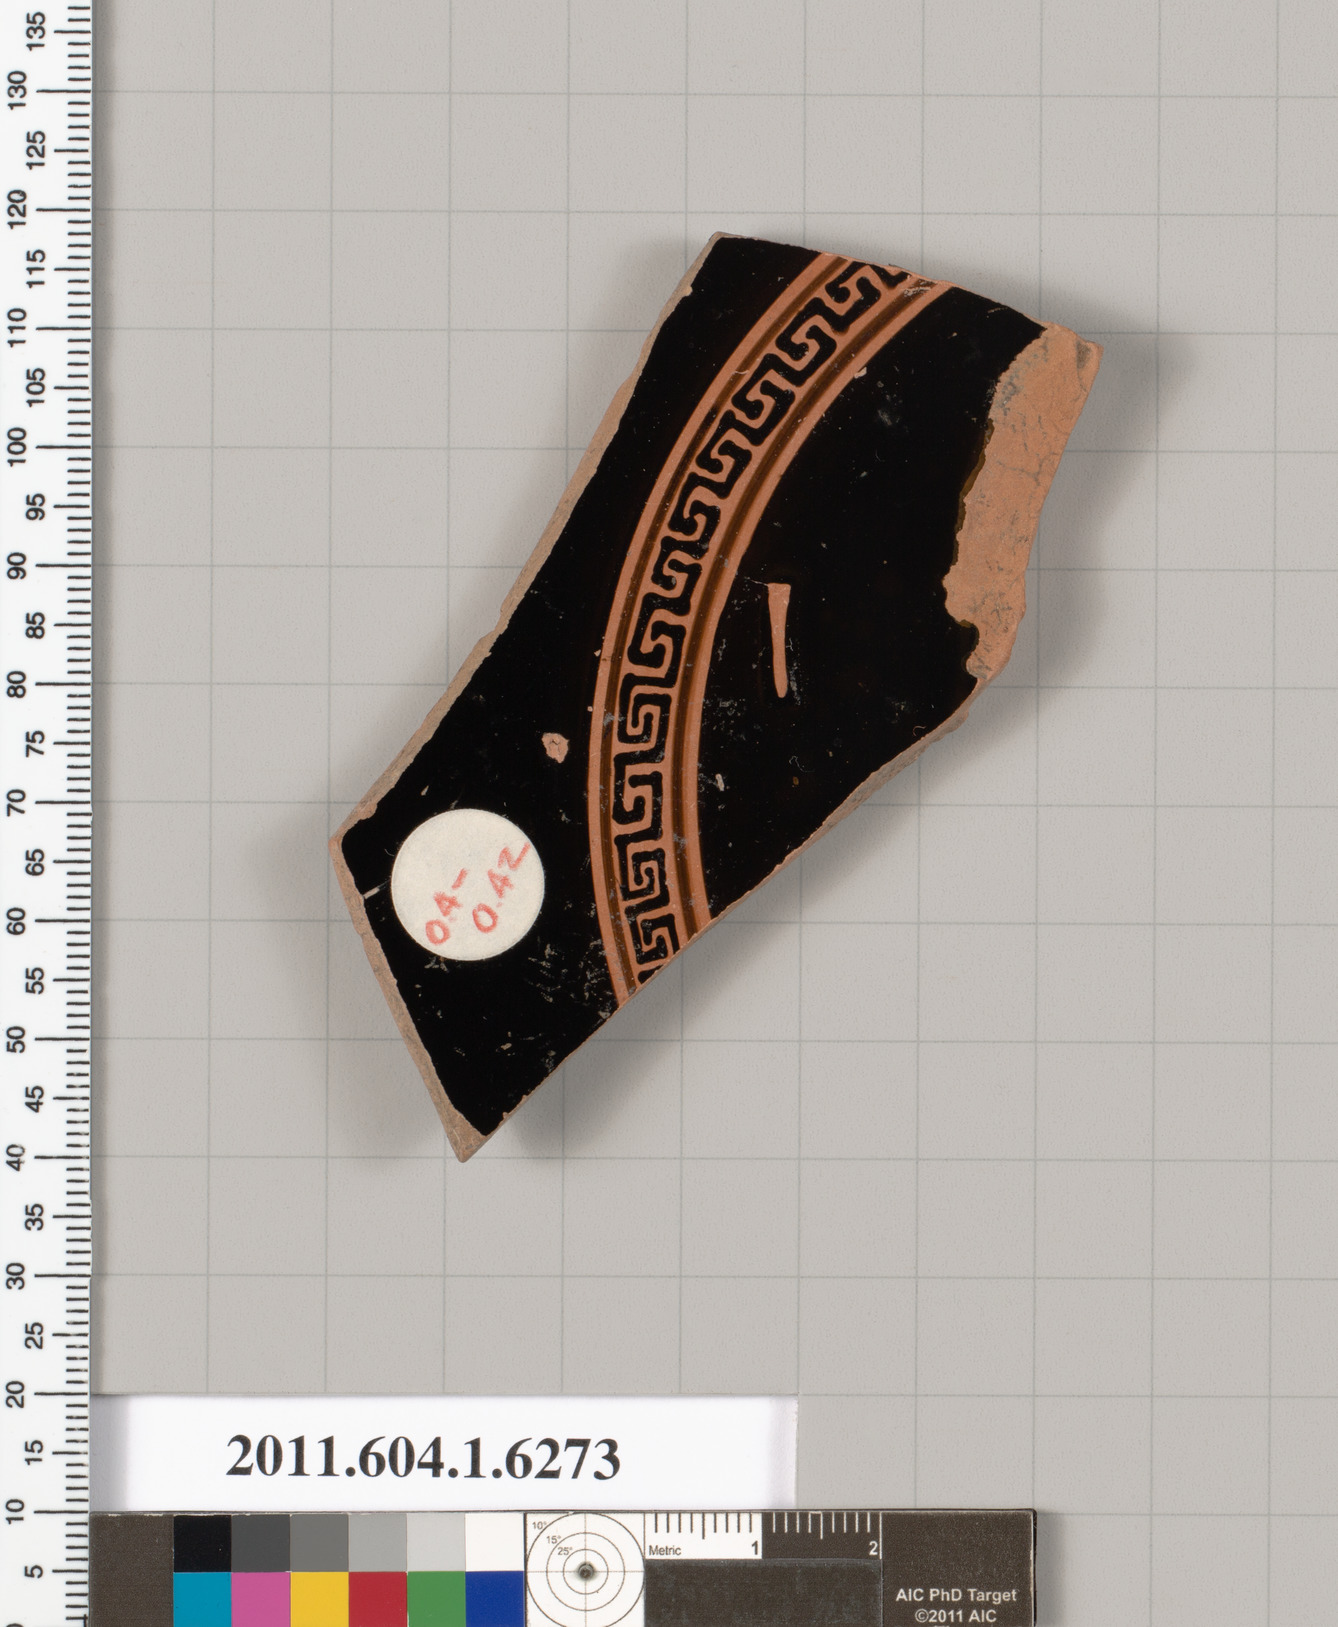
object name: kylix fragment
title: Terracotta fragment of a kylix (drinking cup)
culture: greek, attic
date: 500-480 BCE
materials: terracotta